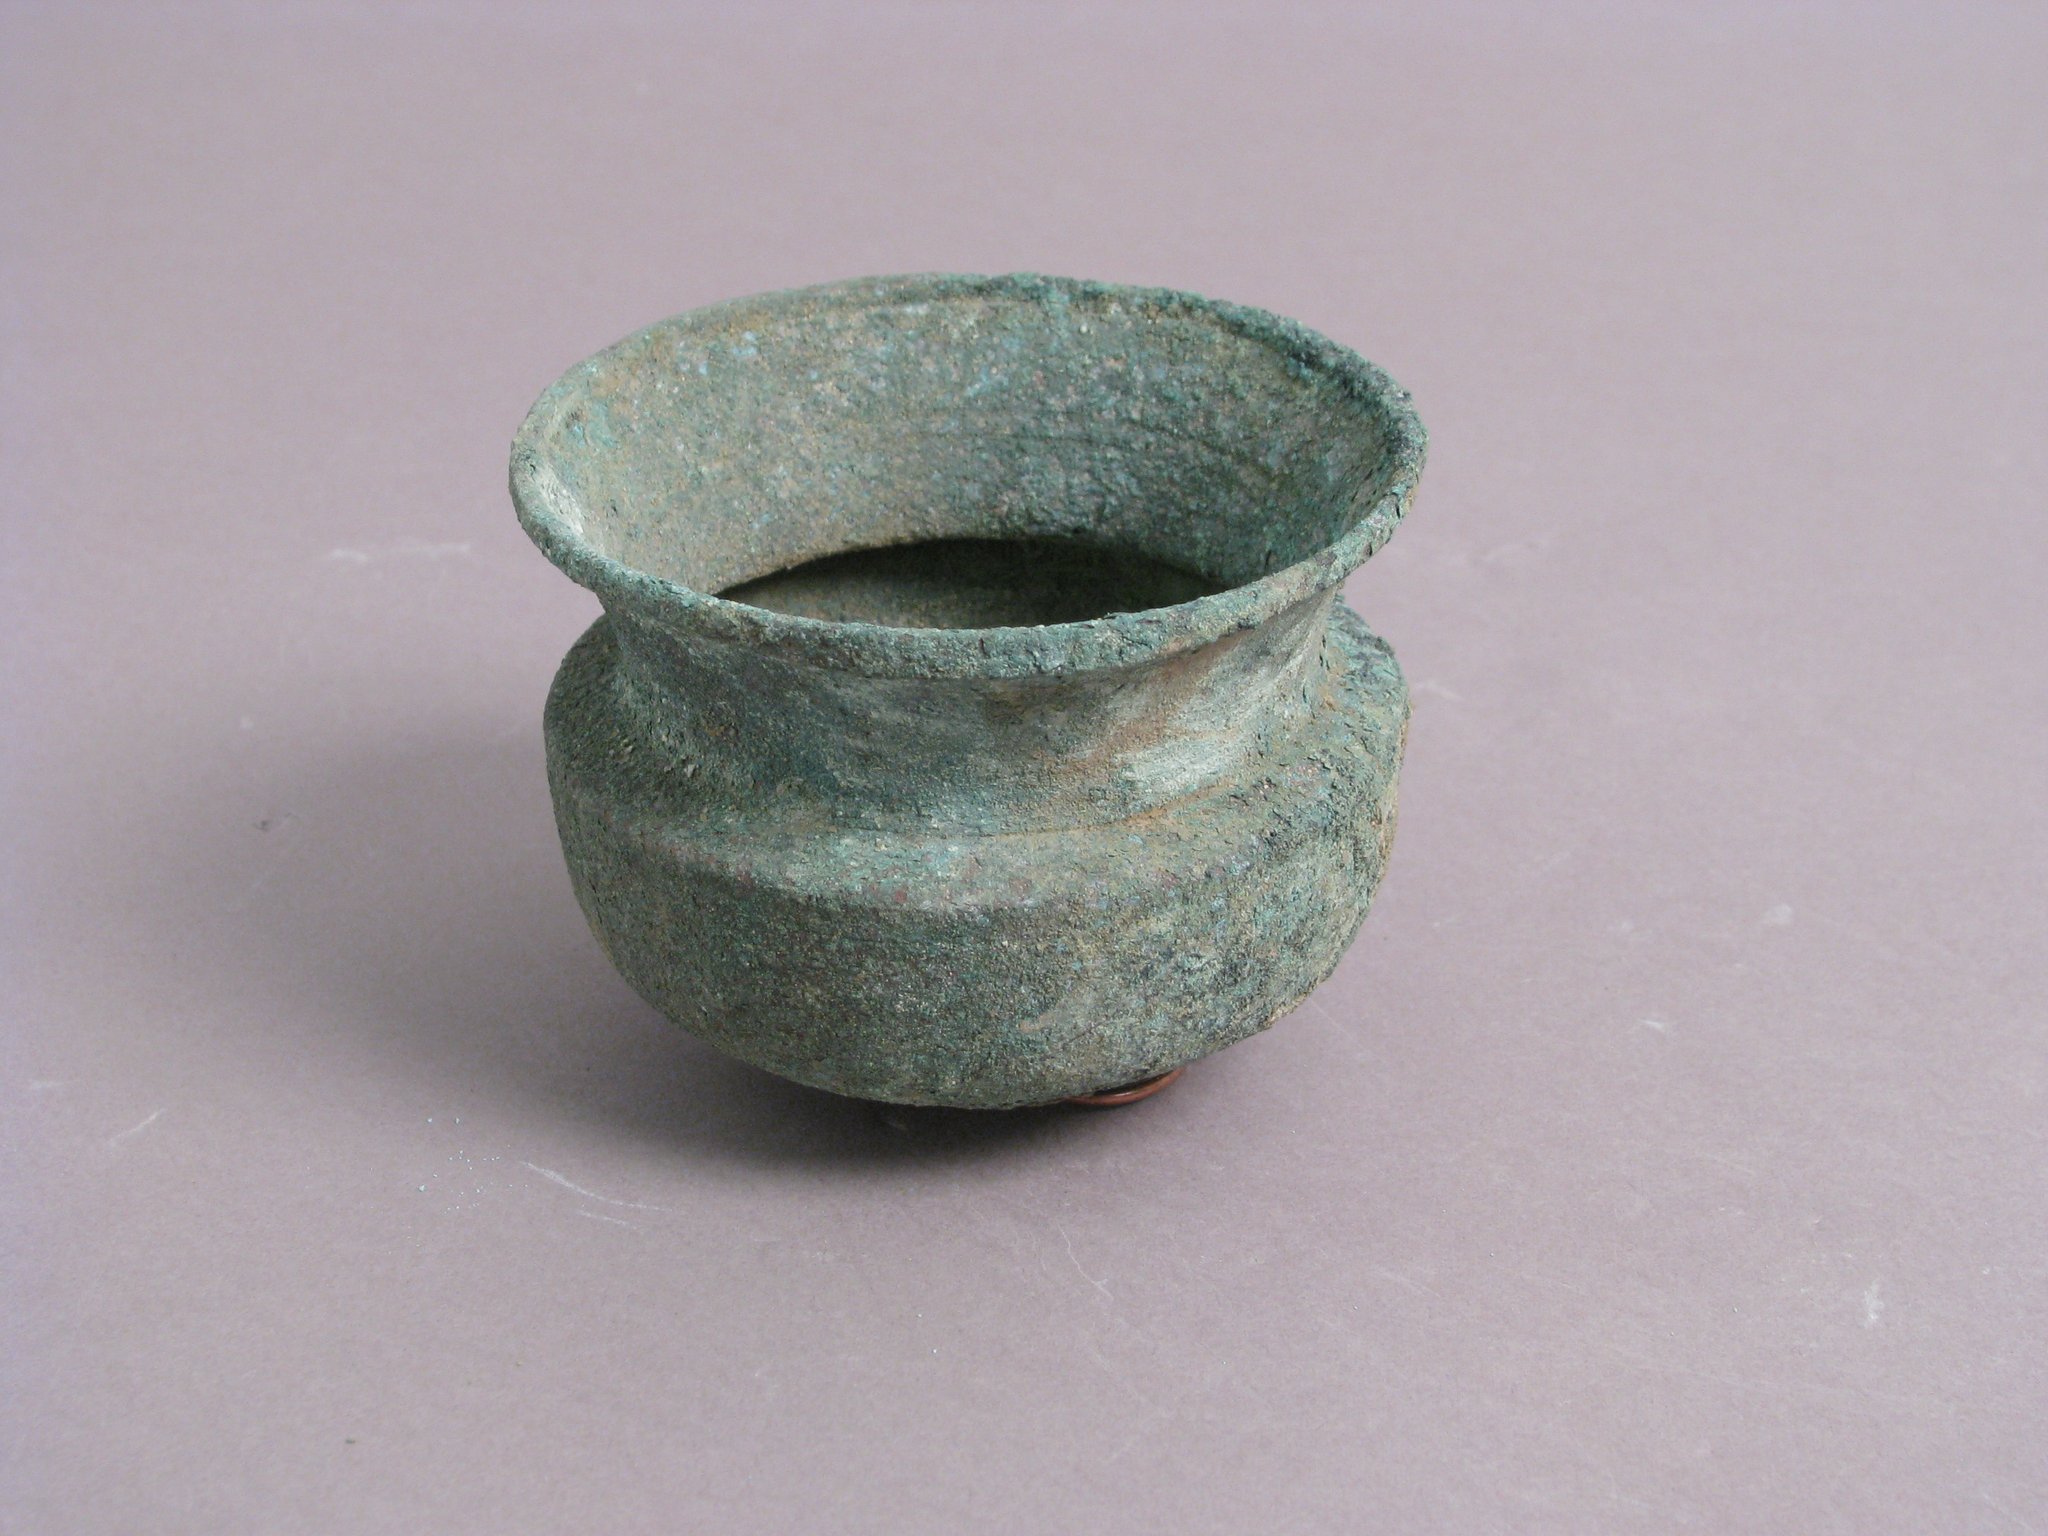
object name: vessel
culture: coptic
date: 301-700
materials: copper alloy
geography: egypt